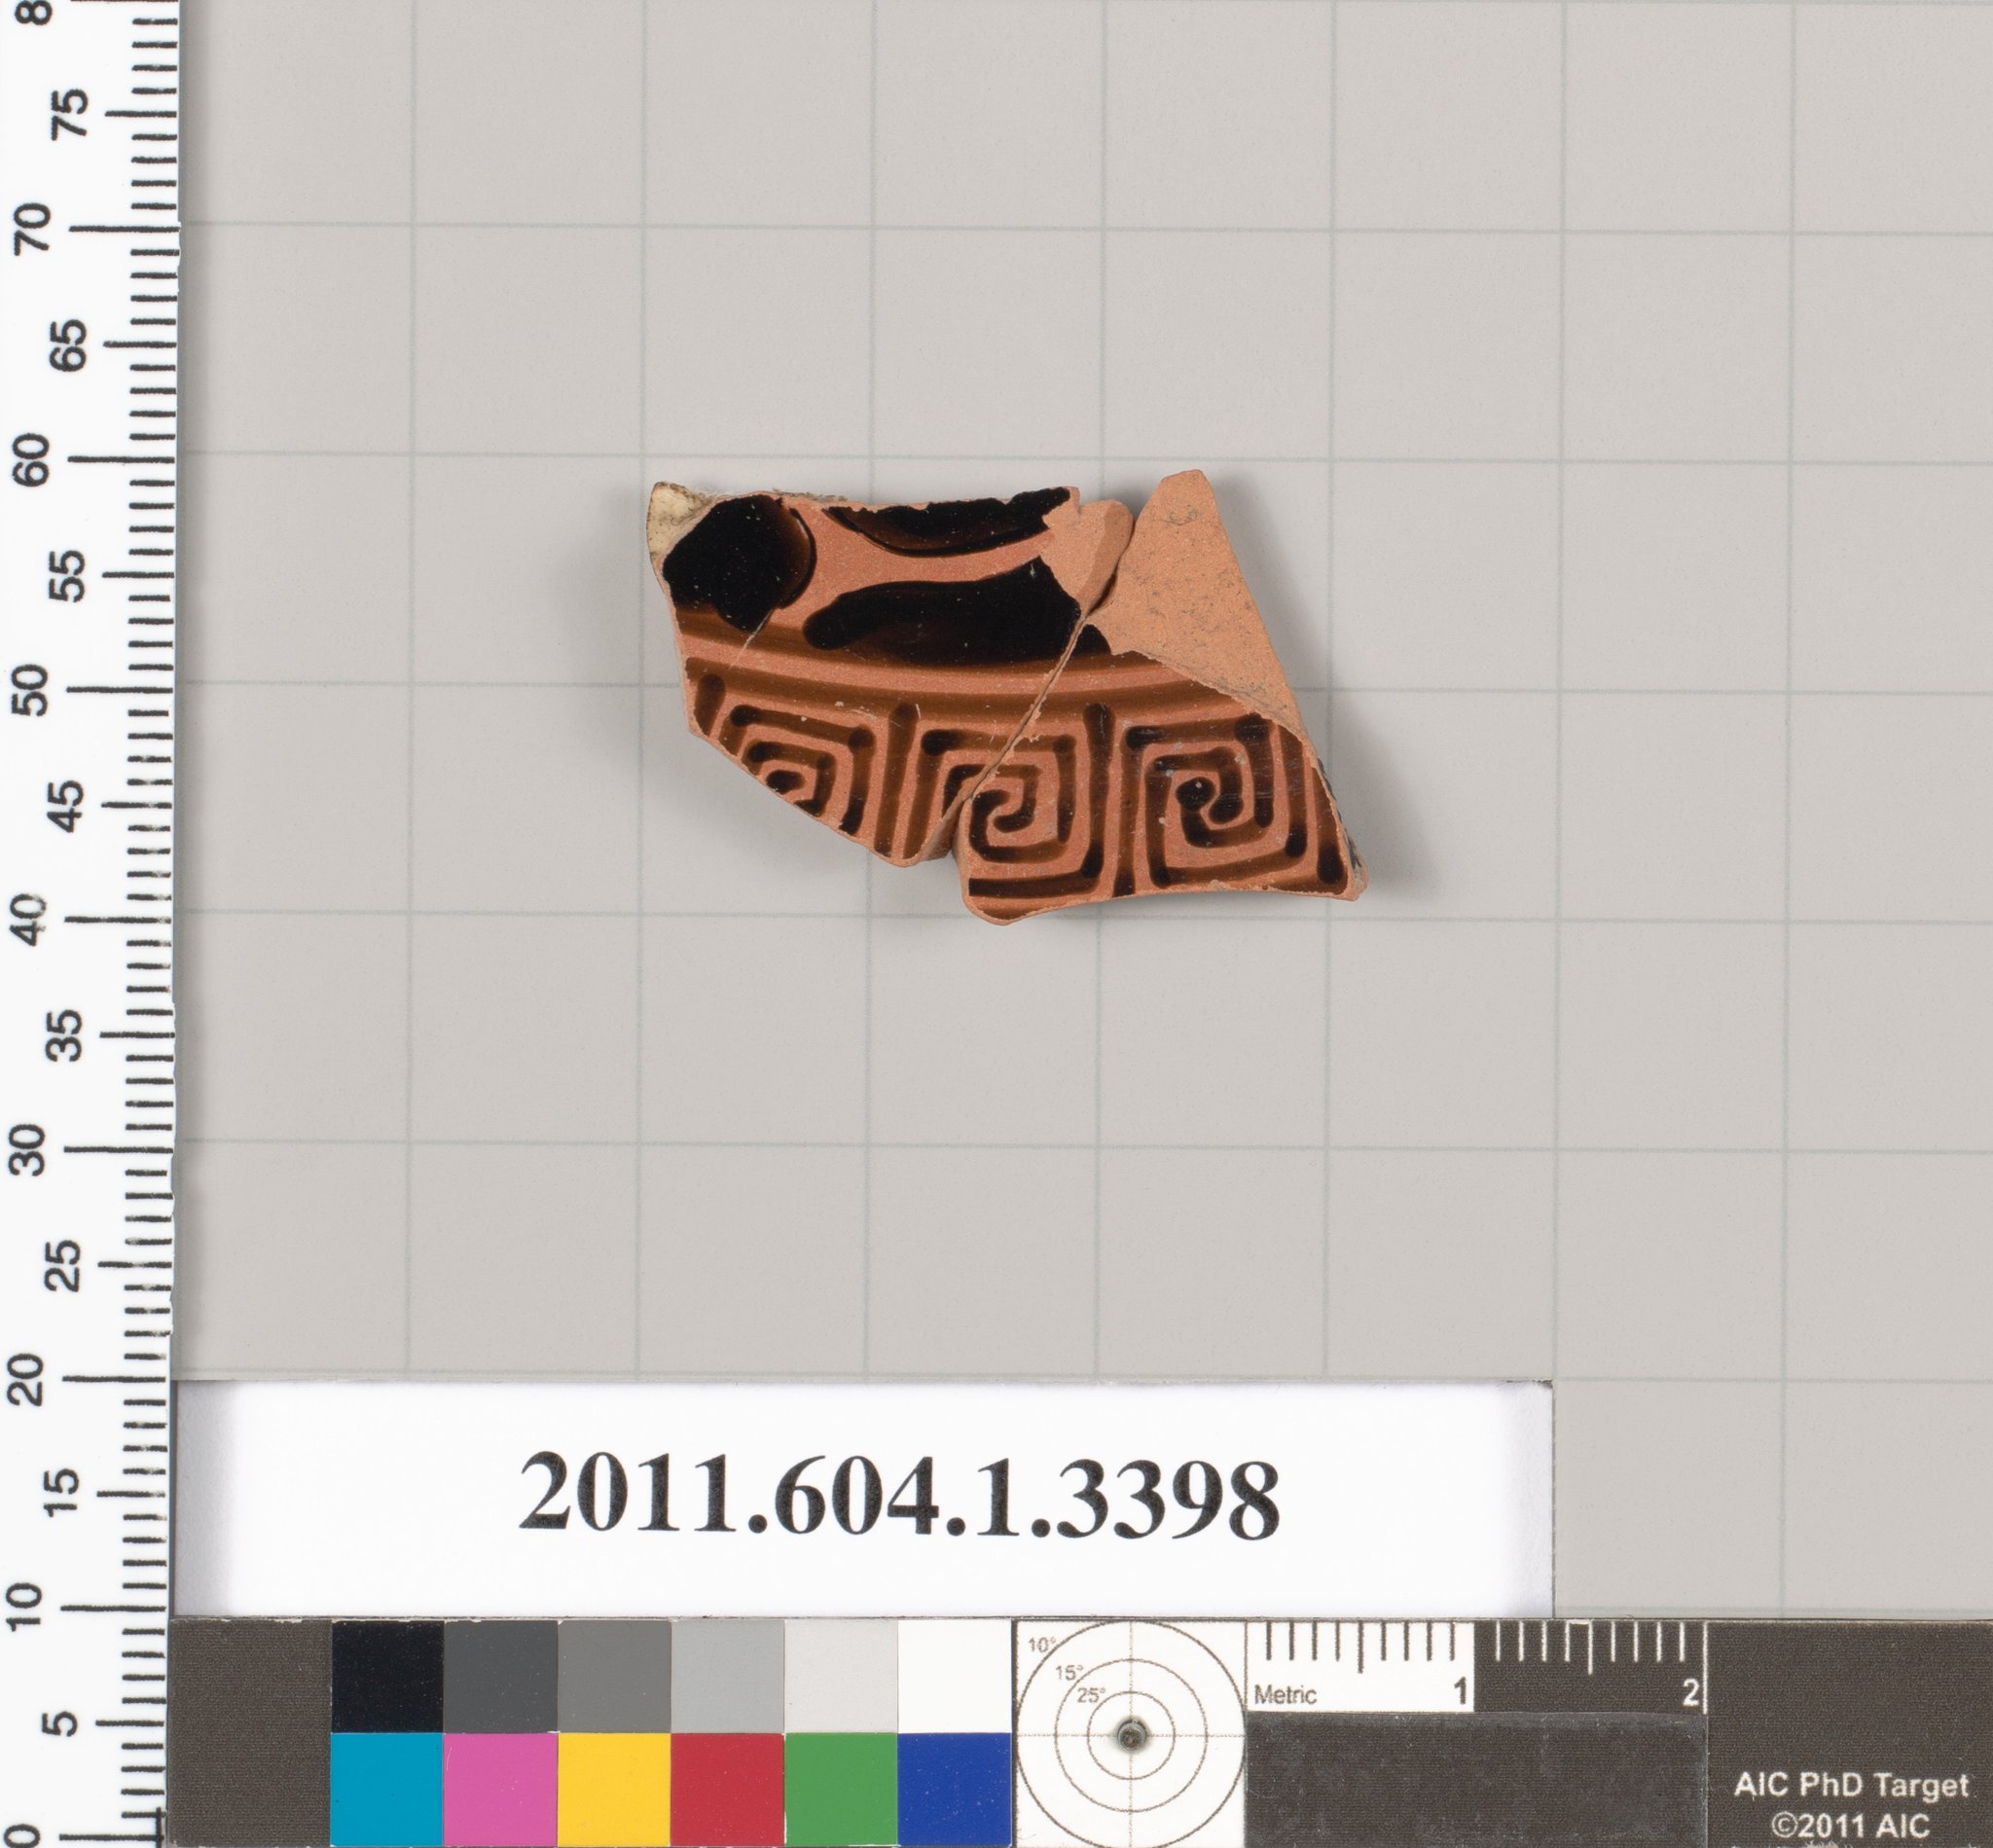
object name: kylix fragment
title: Terracotta fragment of a kylix (drinking cup)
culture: greek, attic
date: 500-476 BCE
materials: terracotta